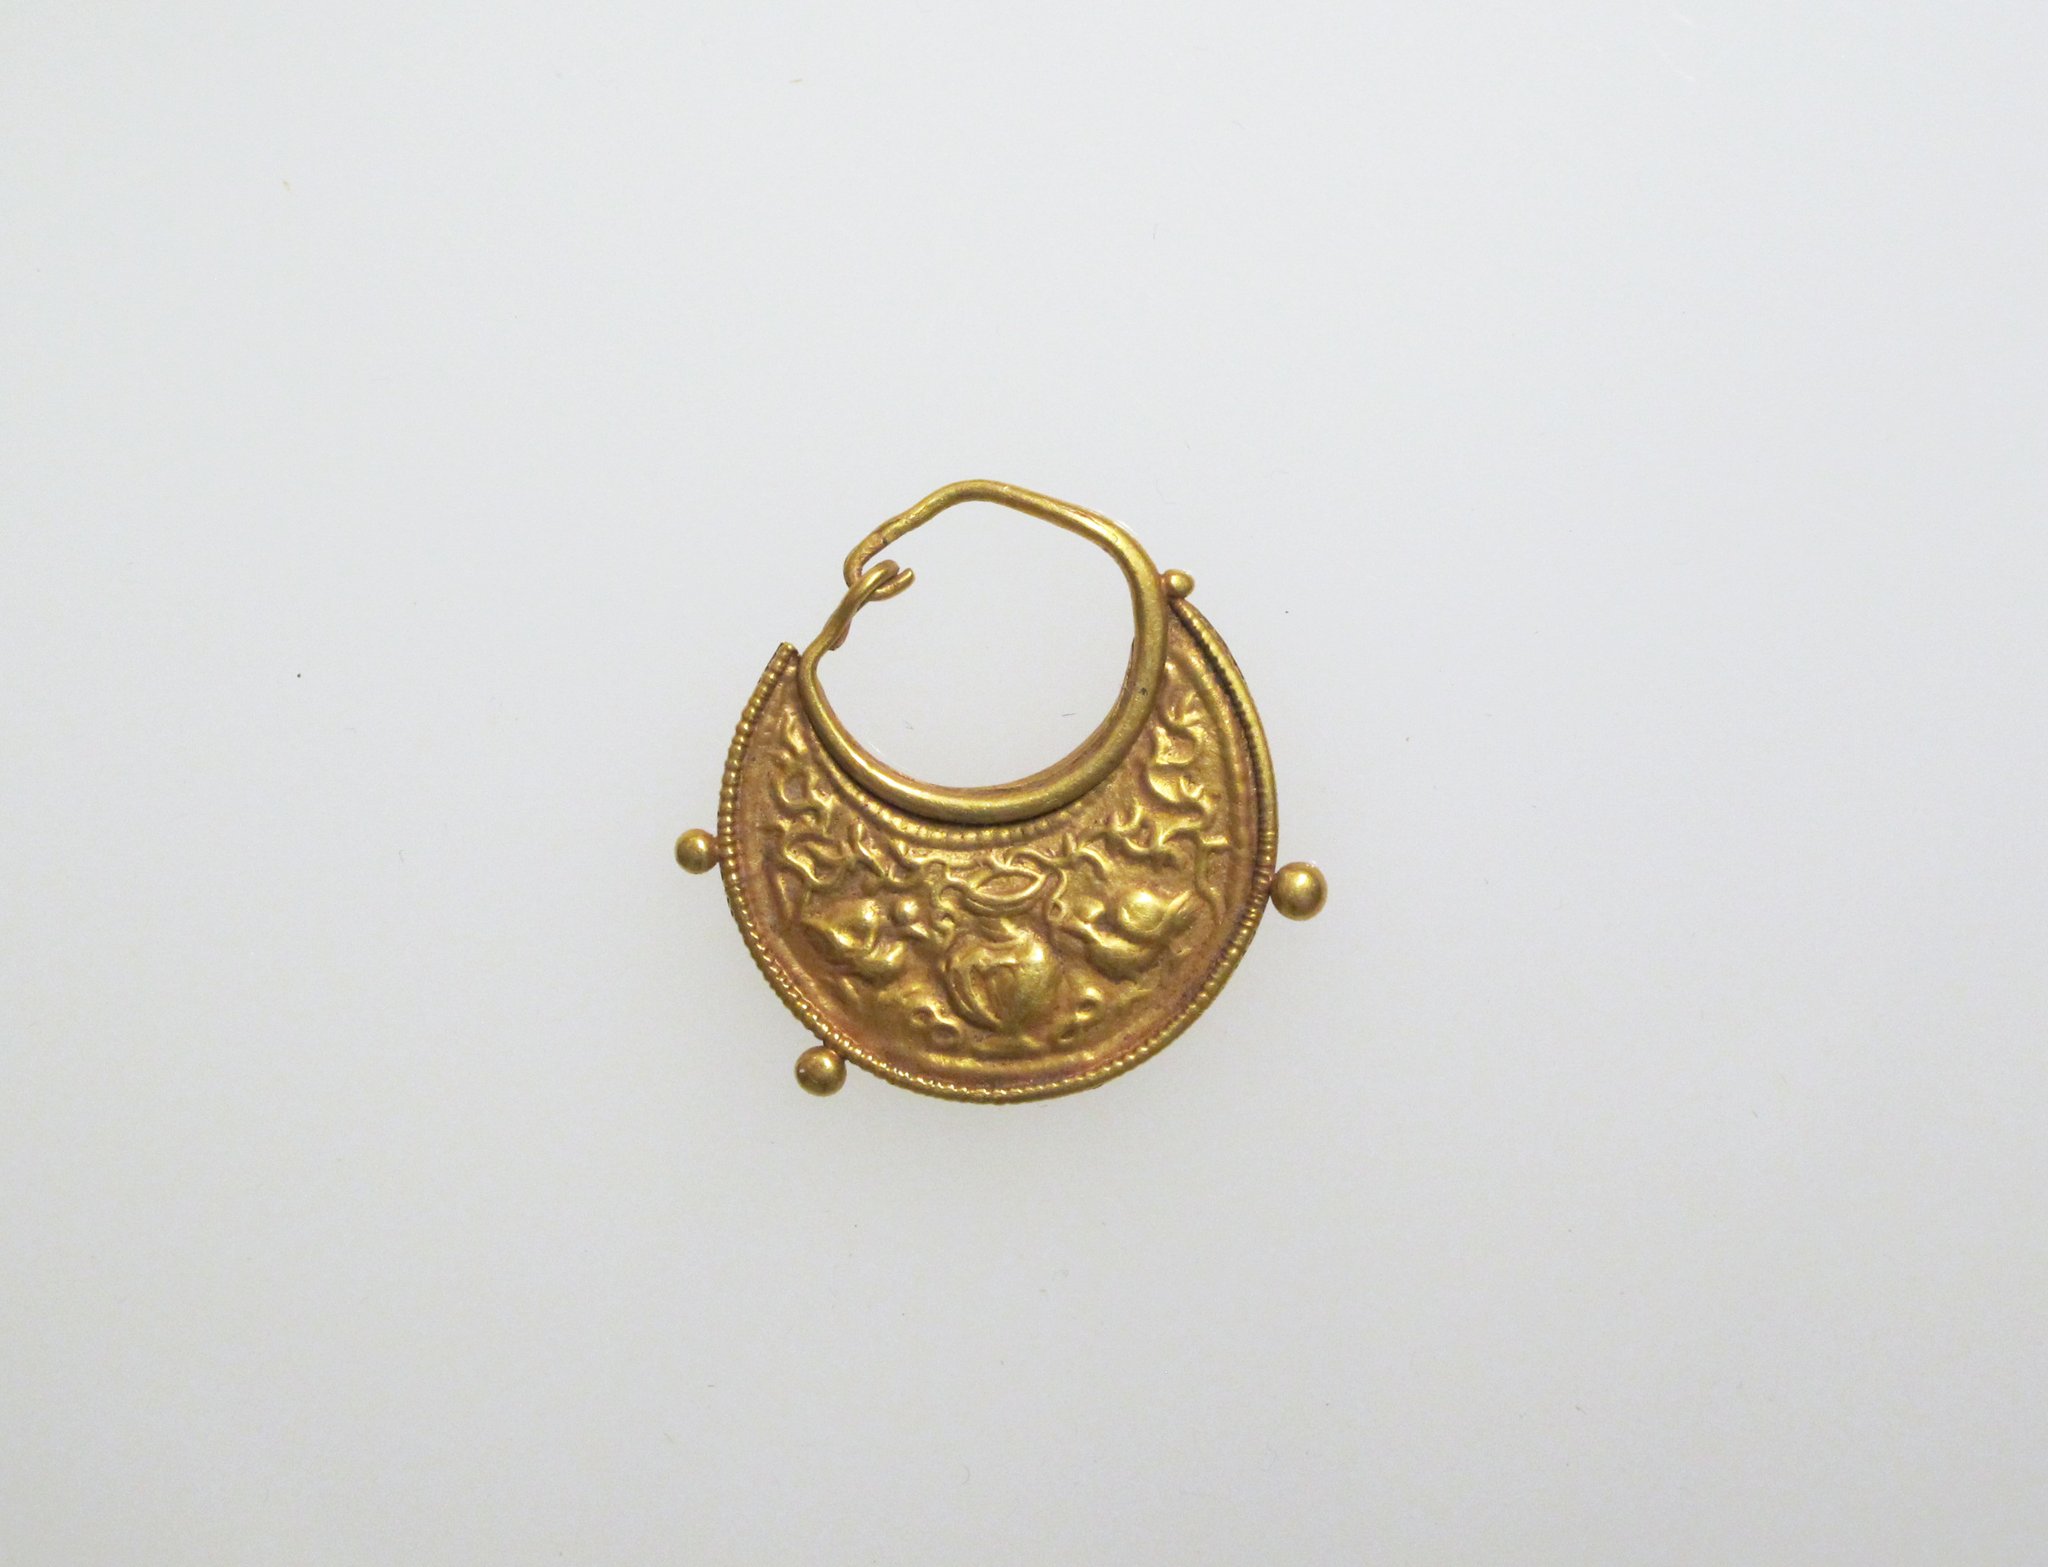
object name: earring, crescent shaped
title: Earring, crescent-shaped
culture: greek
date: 600-401 BCE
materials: gold